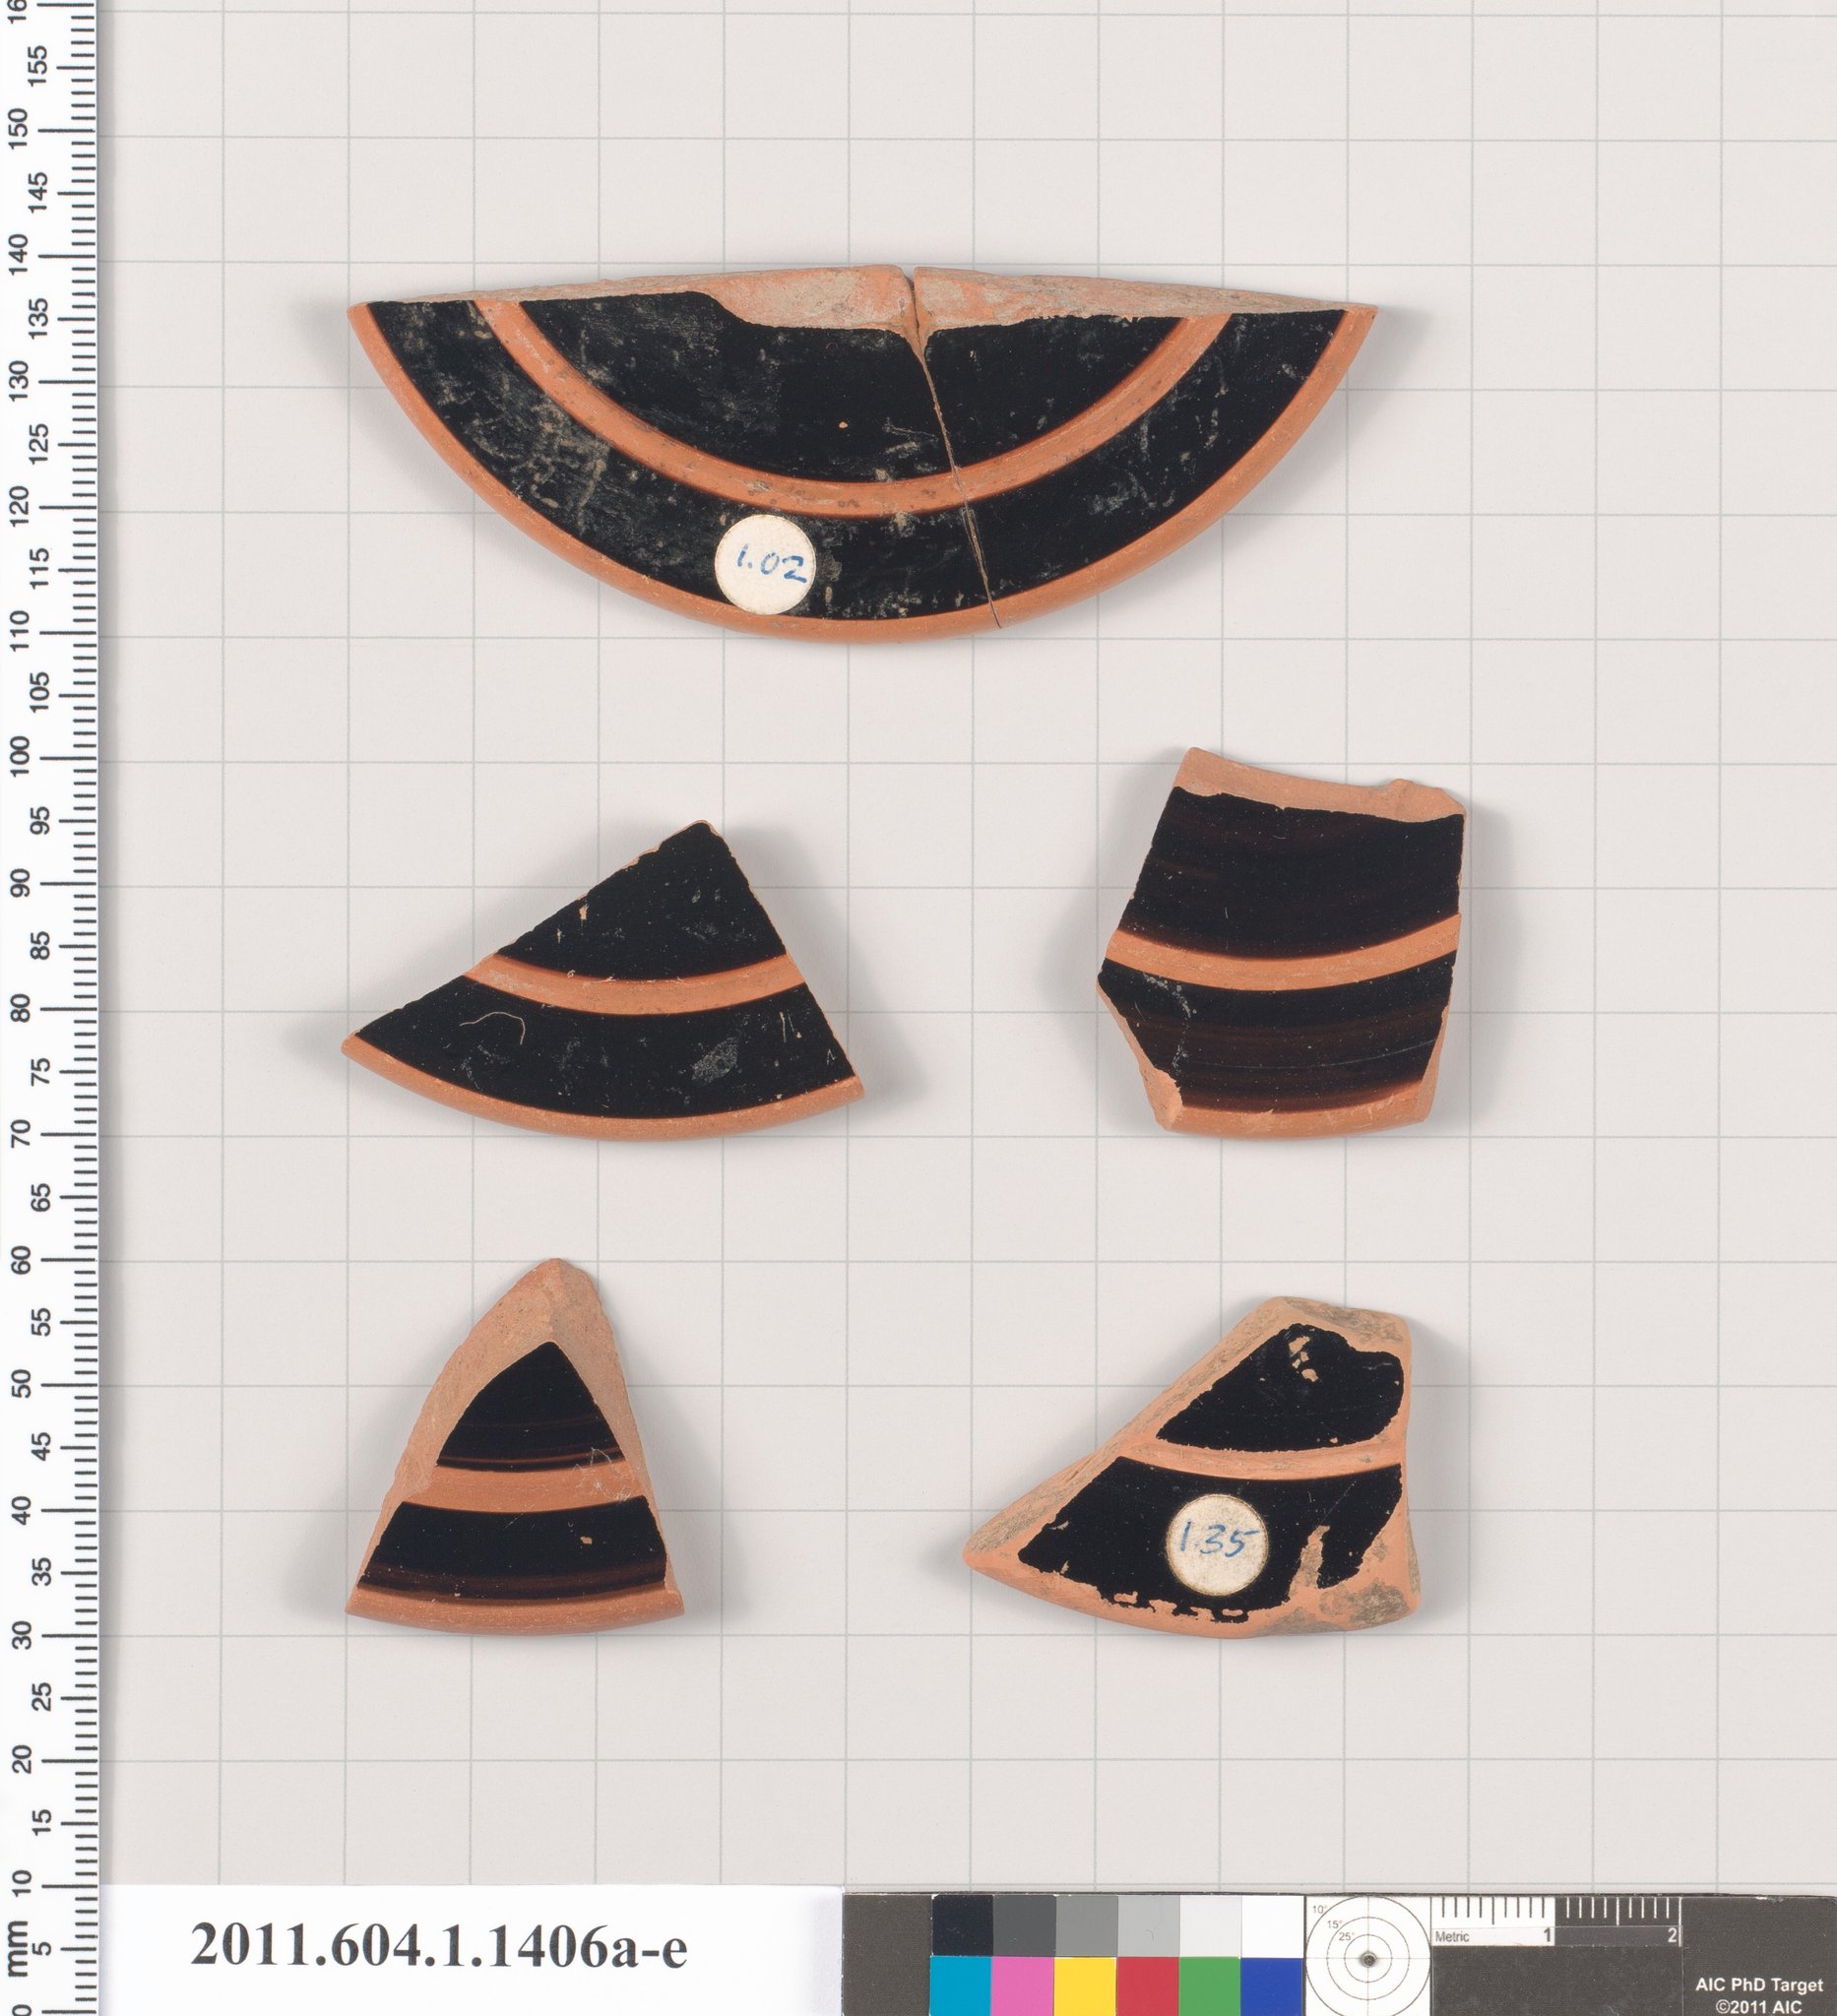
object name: kylix fragment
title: Terracotta fragments of kylikes (drinking cups)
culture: greek, attic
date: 500-401 BCE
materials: terracotta